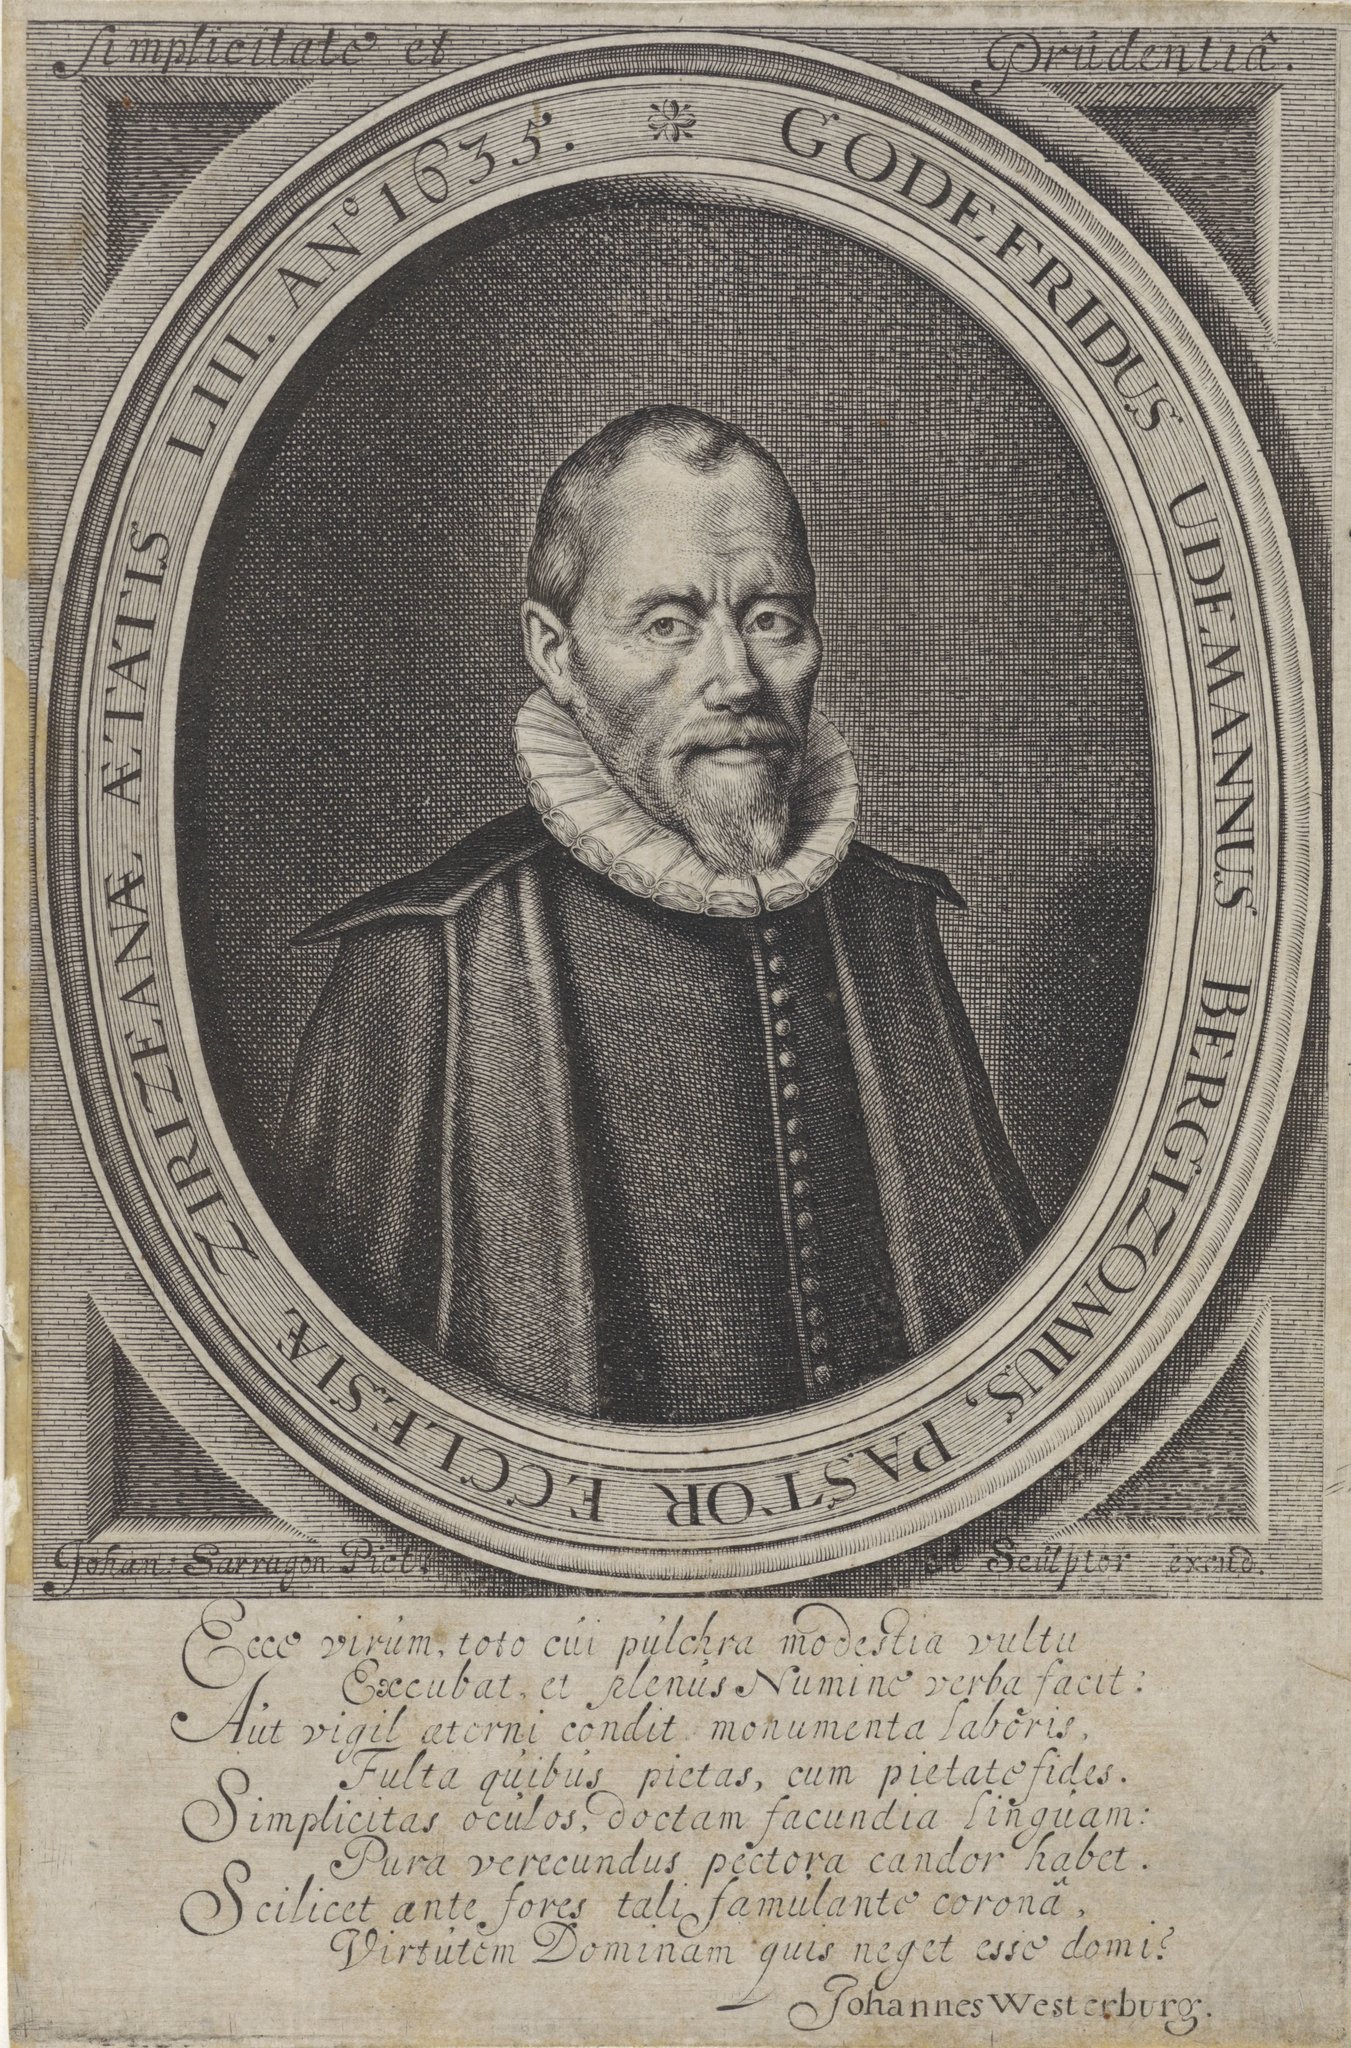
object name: print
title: Portret van Godefridus Cornelisz Udemans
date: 1635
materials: paper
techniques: engraving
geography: middelburg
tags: historical persons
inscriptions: collector's mark: Lugt 2228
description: Buste naar rechts van de Zeeuwse predikant Godefridus Cornelisz Udemans in een omlijsting met Latijns randschrift. Het randschrift beschrijft de naam, functie en leeftijd van de geportretteerde. Onder de voorstelling een achtregelig, Latijns lofdicht.